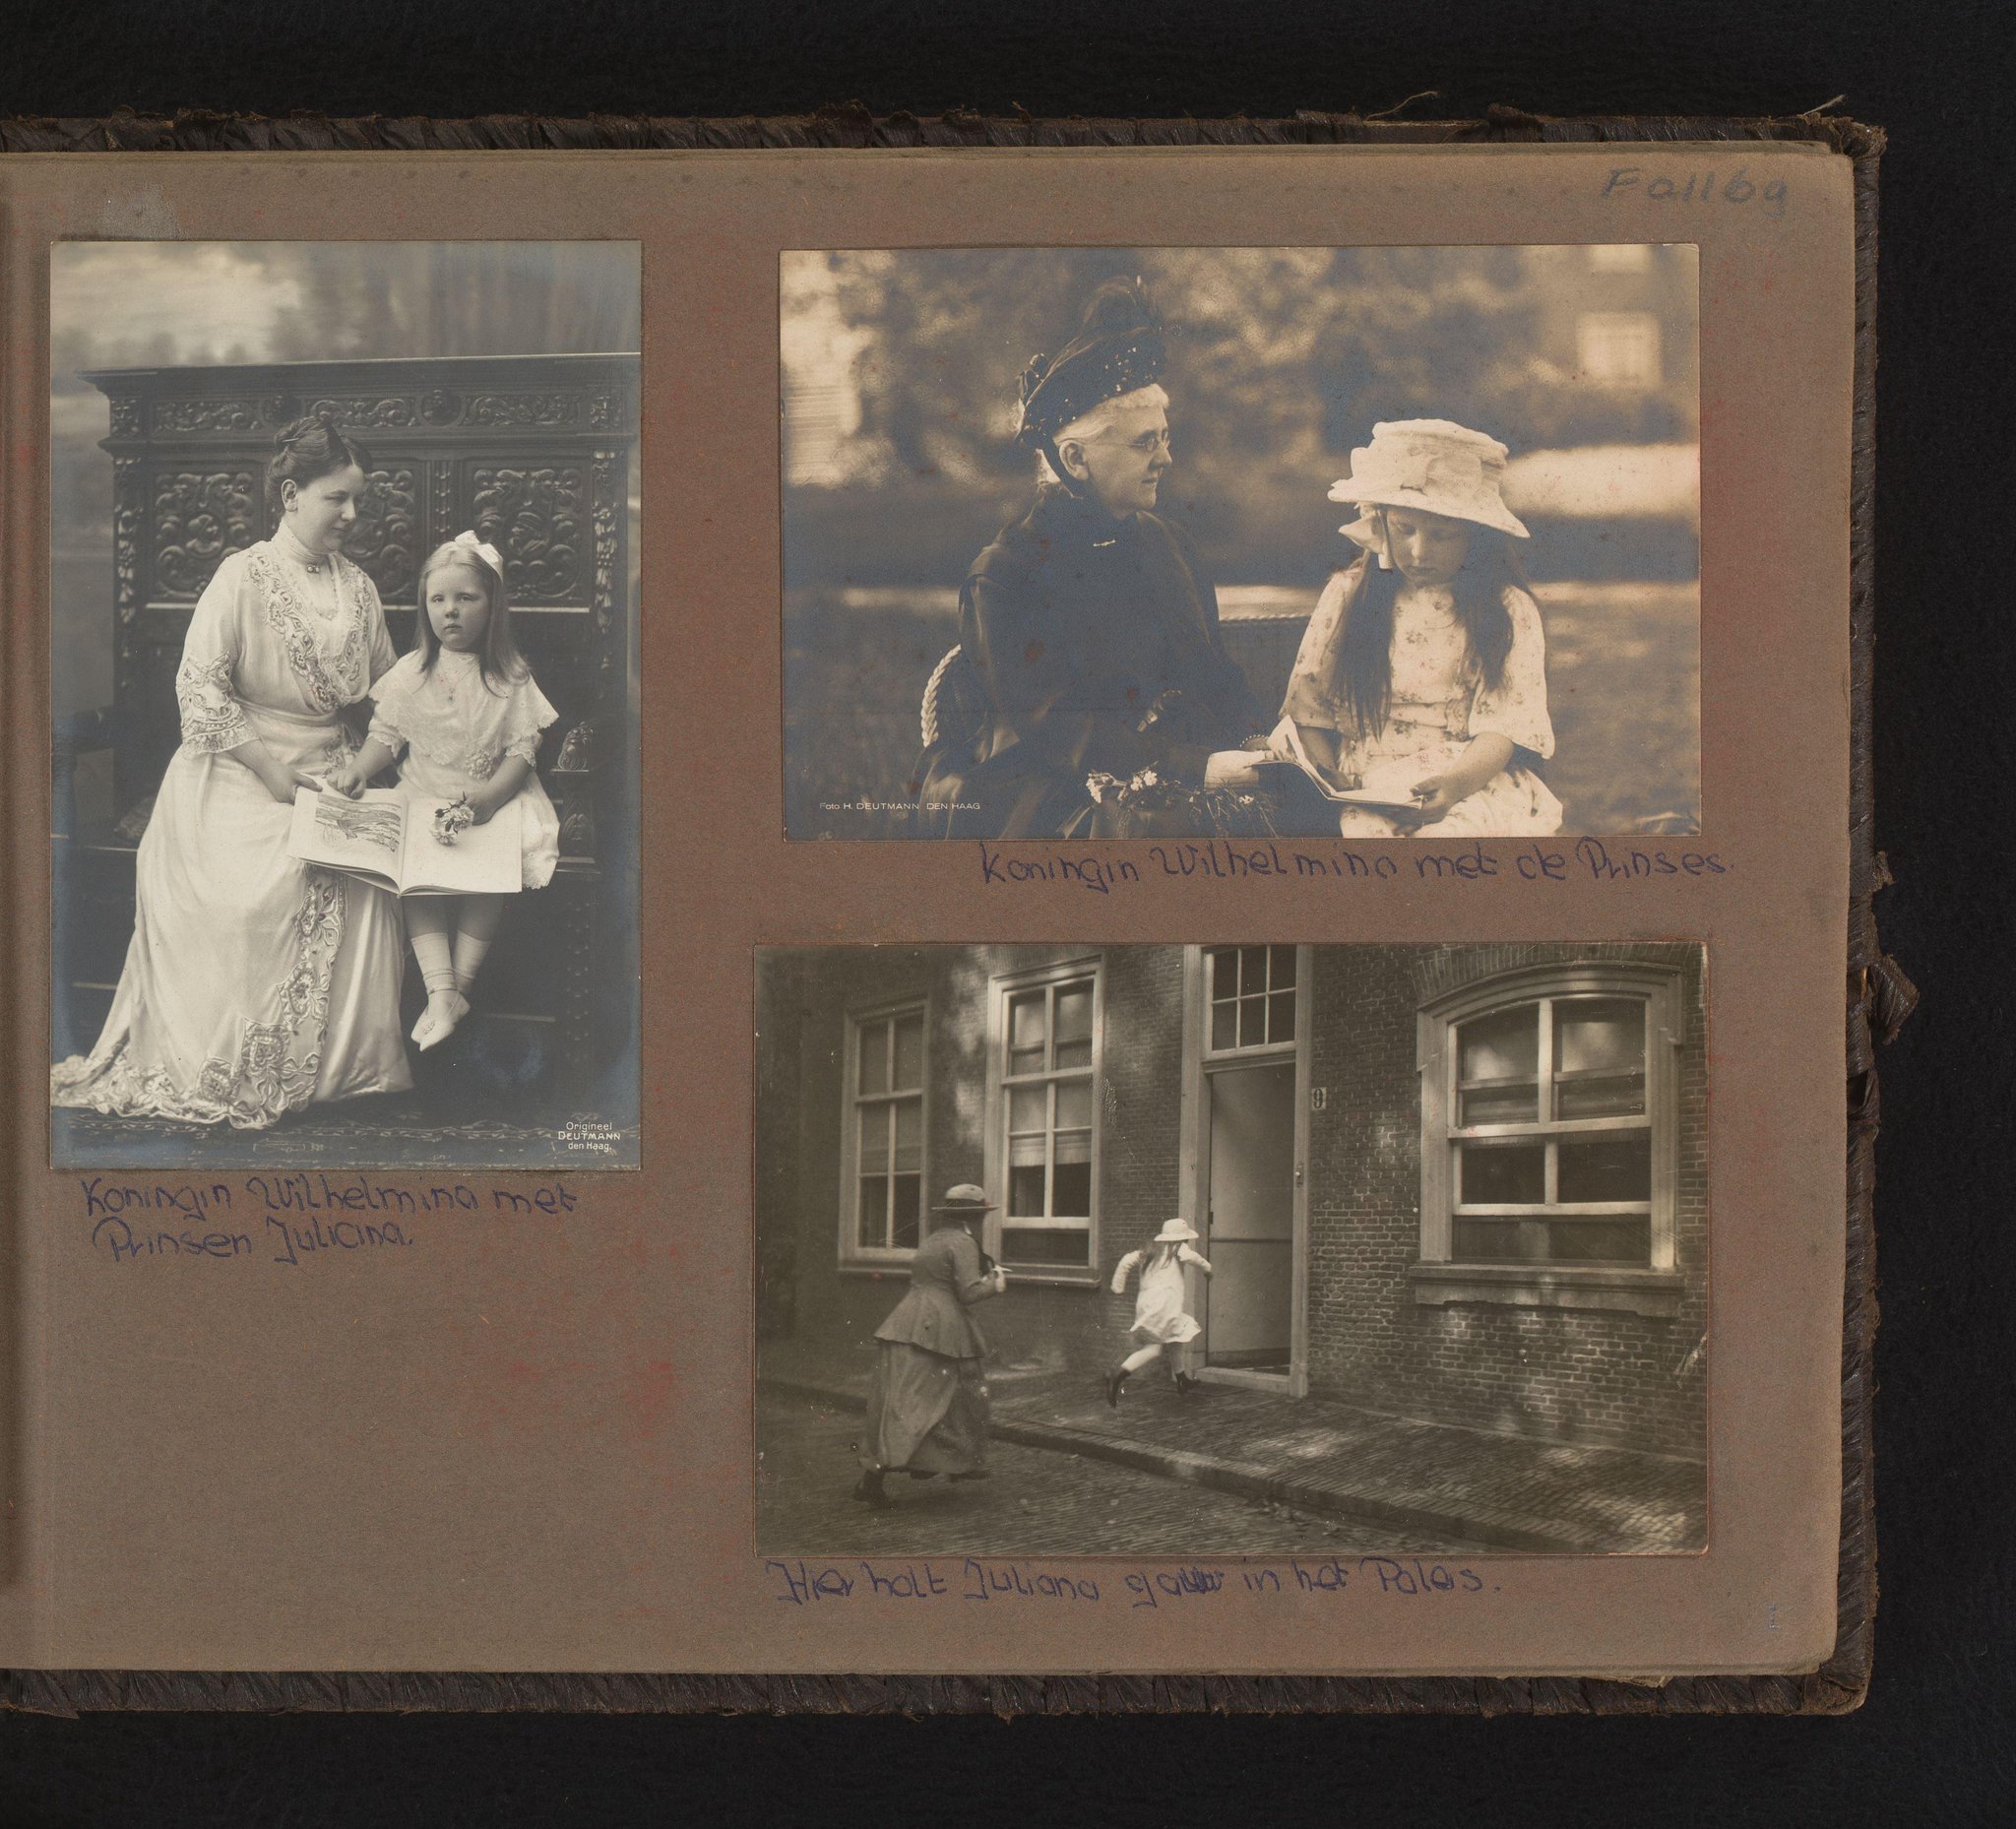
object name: album leaf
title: Drie foto's van prinses Juliana als kind, samen met koningin Wilhelmina en met koningin-moeder Emma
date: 1914-1920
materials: paper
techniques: gelatin silver print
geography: the hague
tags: the hague, print maker, wilhelmina of the netherlands, emma (queen consort of the netherlands), juliana of the netherlands, adult woman, girl (child between toddler and youth), old woman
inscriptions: annotation: ‘Koningin Wilhelmina met/ Prinses Juliana.’, inscription: ‘Foto H. Deutmann Den Haag’, annotation: ‘Hier holt Juliana gauw in het Paleis.’, annotation: ‘Koningin Wilhelmina met de Prinses.’, inscription: ‘Origineel/ Deutmann/ Den Haag.’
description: Deze foto's maken deel uit van een album.